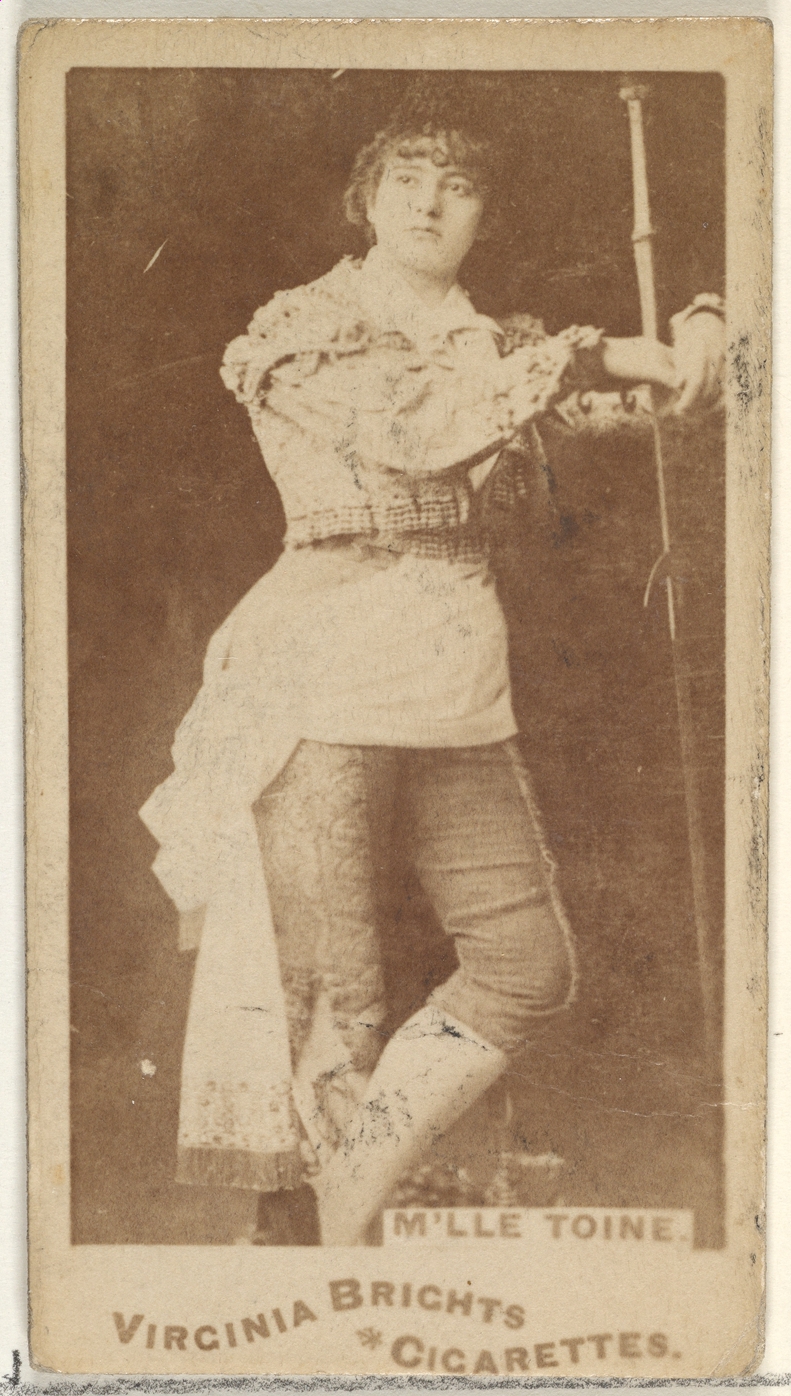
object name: photograph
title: M'lle Toine, from the Actors and Actresses series (N45, Type 1) for Virginia Brights Cigarettes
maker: allen & ginter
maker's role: publisher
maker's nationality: american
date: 1888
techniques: albumen silver print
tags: portraits,women,actresses